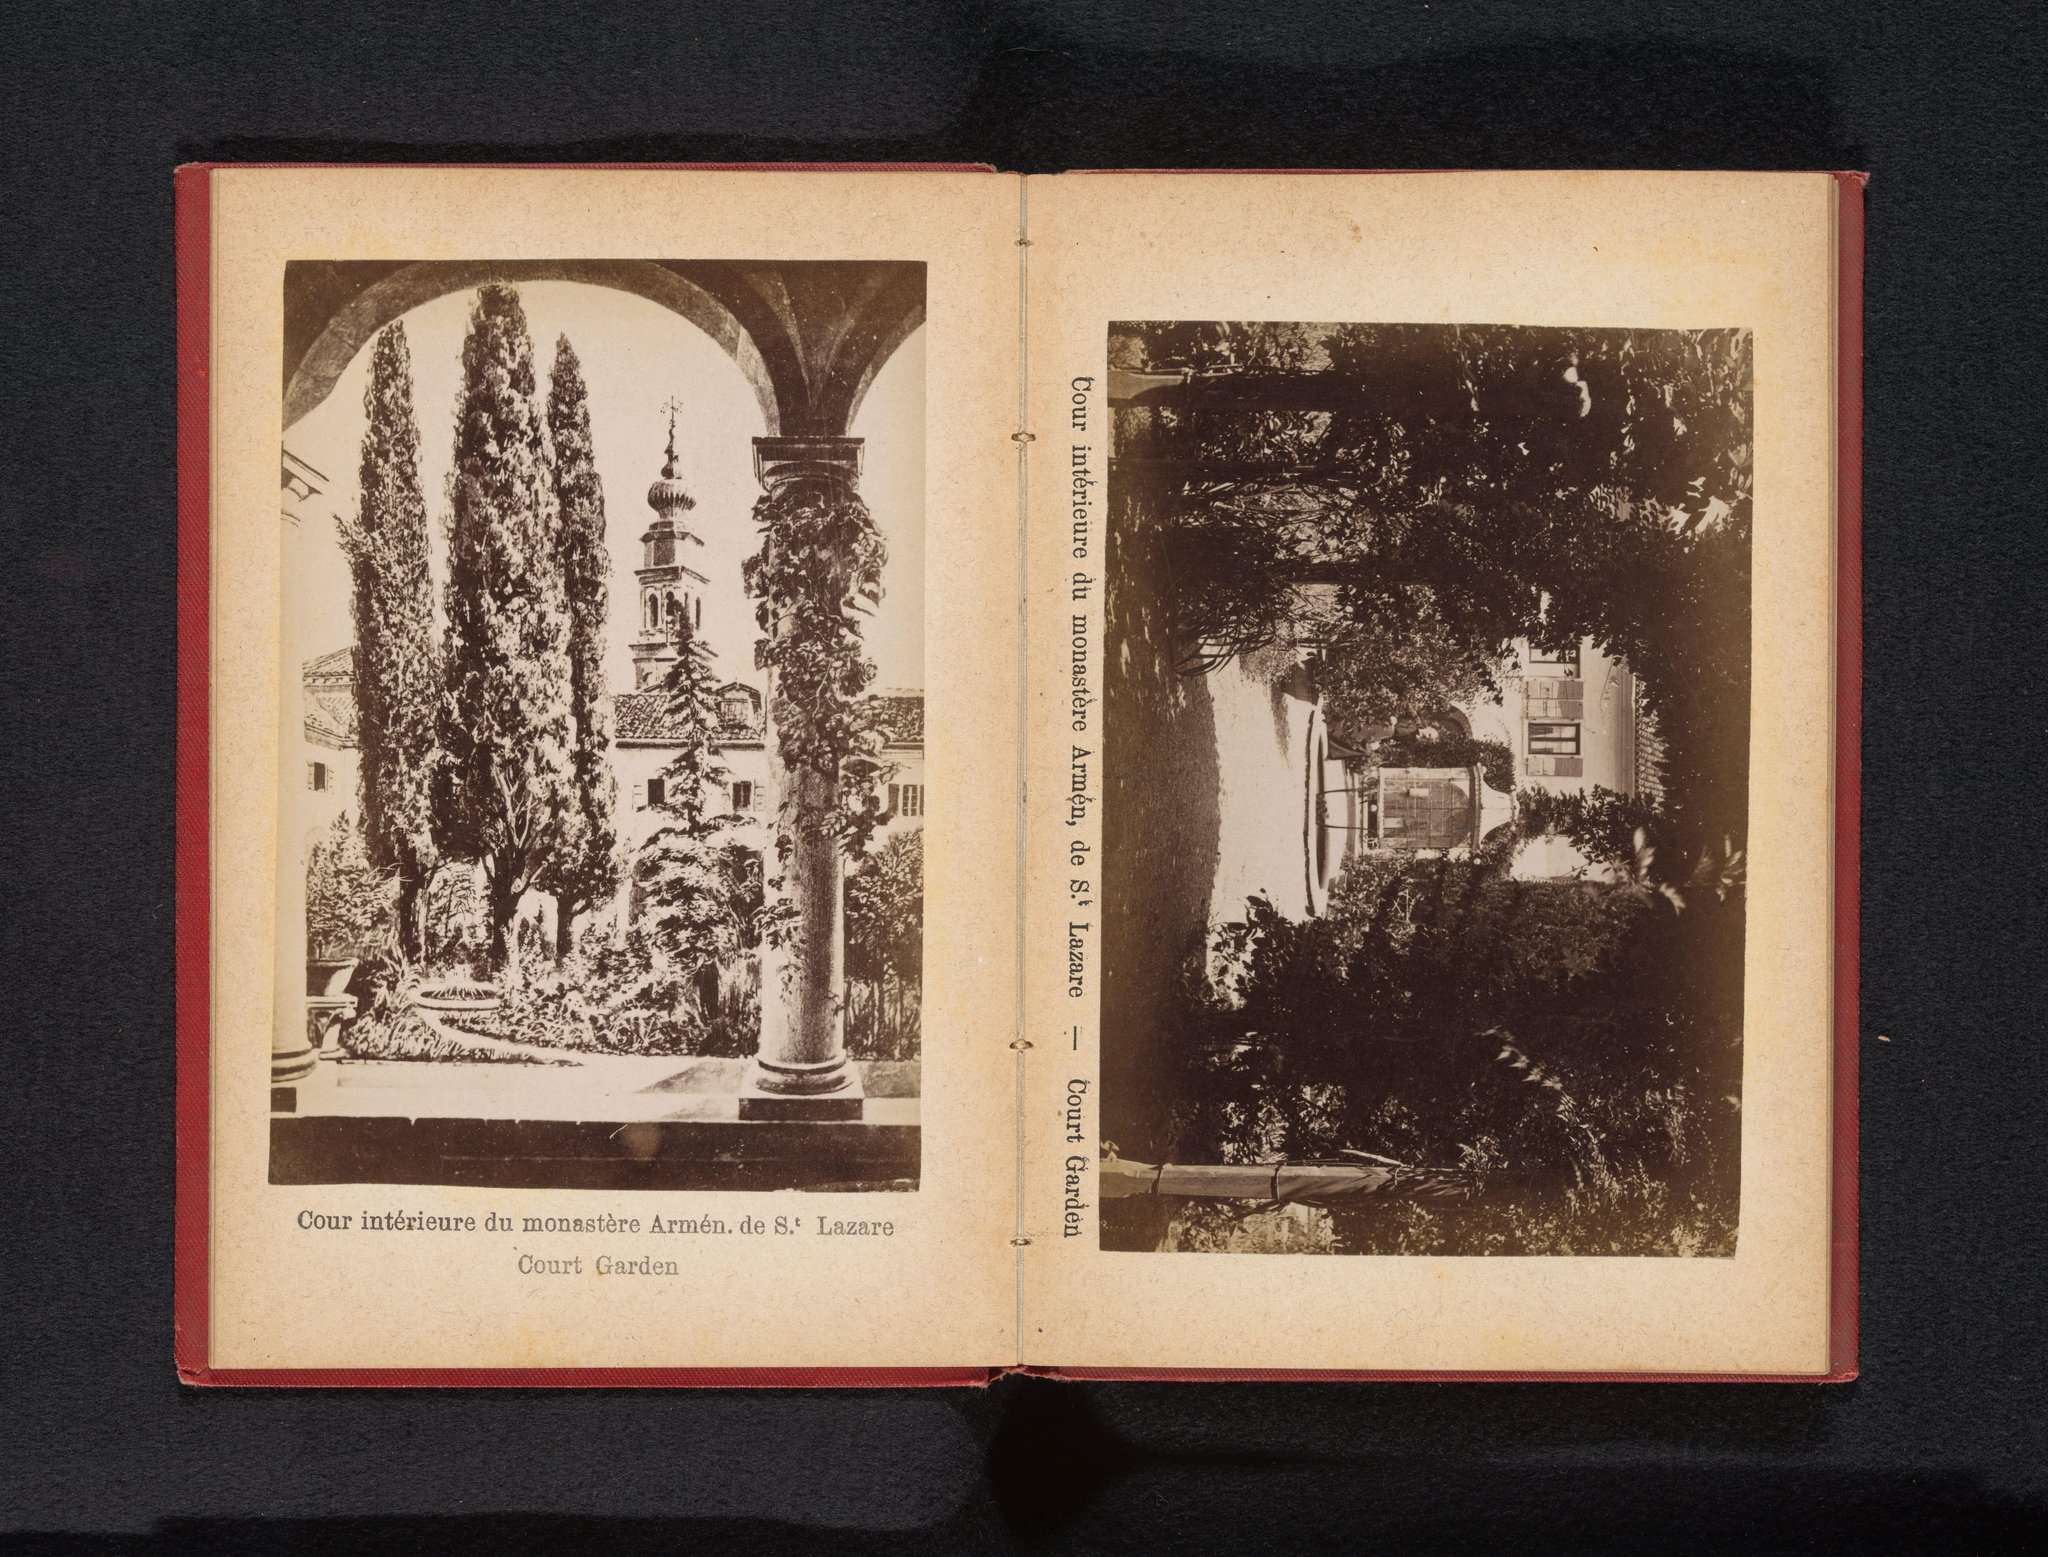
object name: photograph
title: Court garden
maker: Anonymous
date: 1870-1880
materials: paper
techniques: albumen print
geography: san lazzaro degli armeni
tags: abbey garden